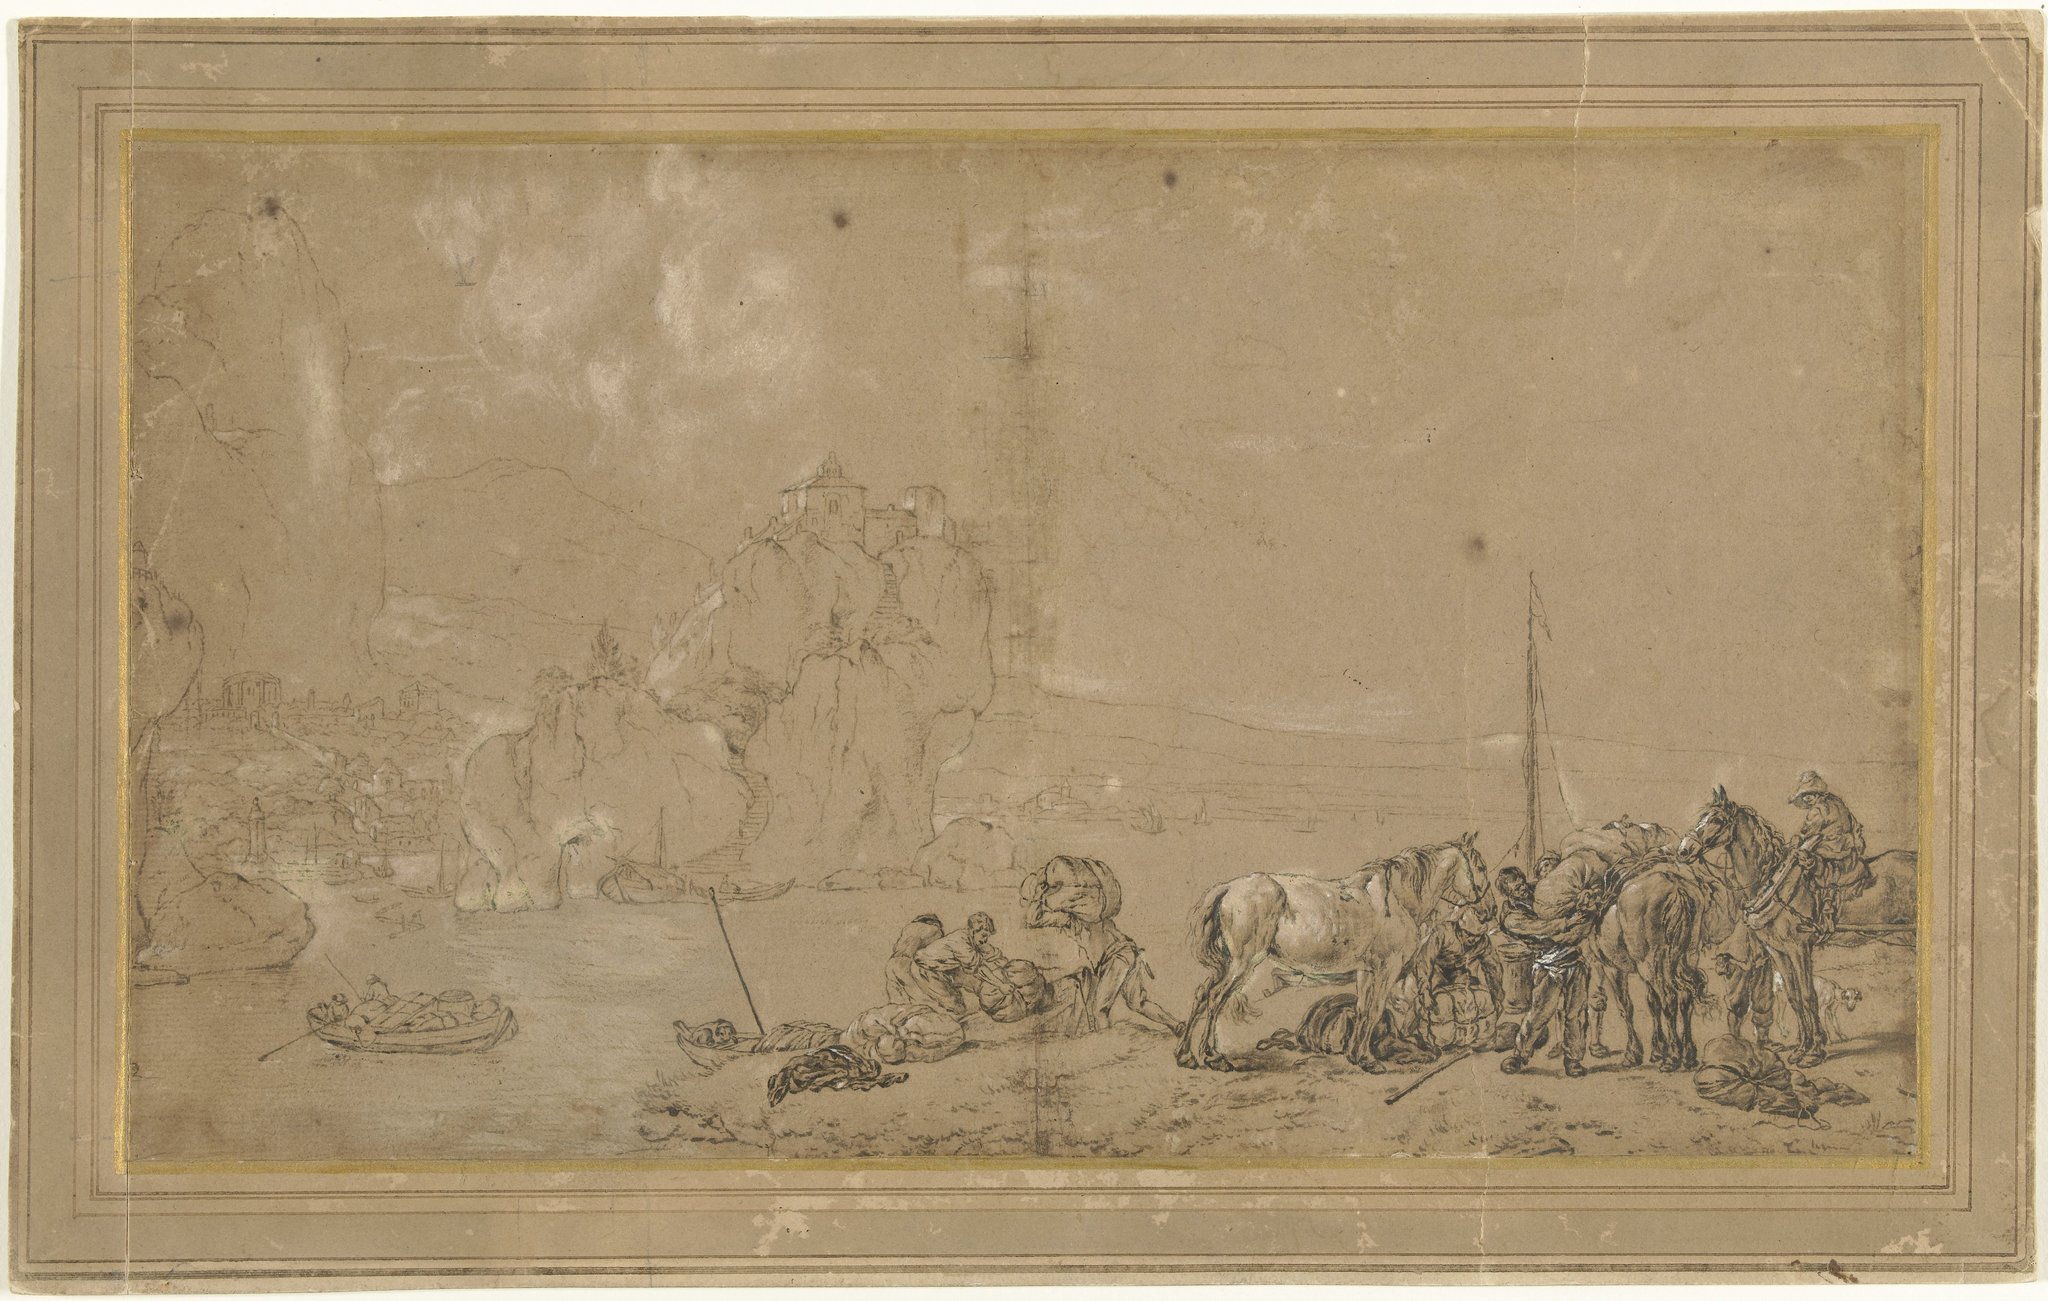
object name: drawing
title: Coastal Scene with the Embarkation of Goods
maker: Anonymous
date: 1625-1699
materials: paint, ink, paper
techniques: brush, pen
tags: low hill country, river, ferry (+ loading), animal mounts; pack-animals (+ unloading)